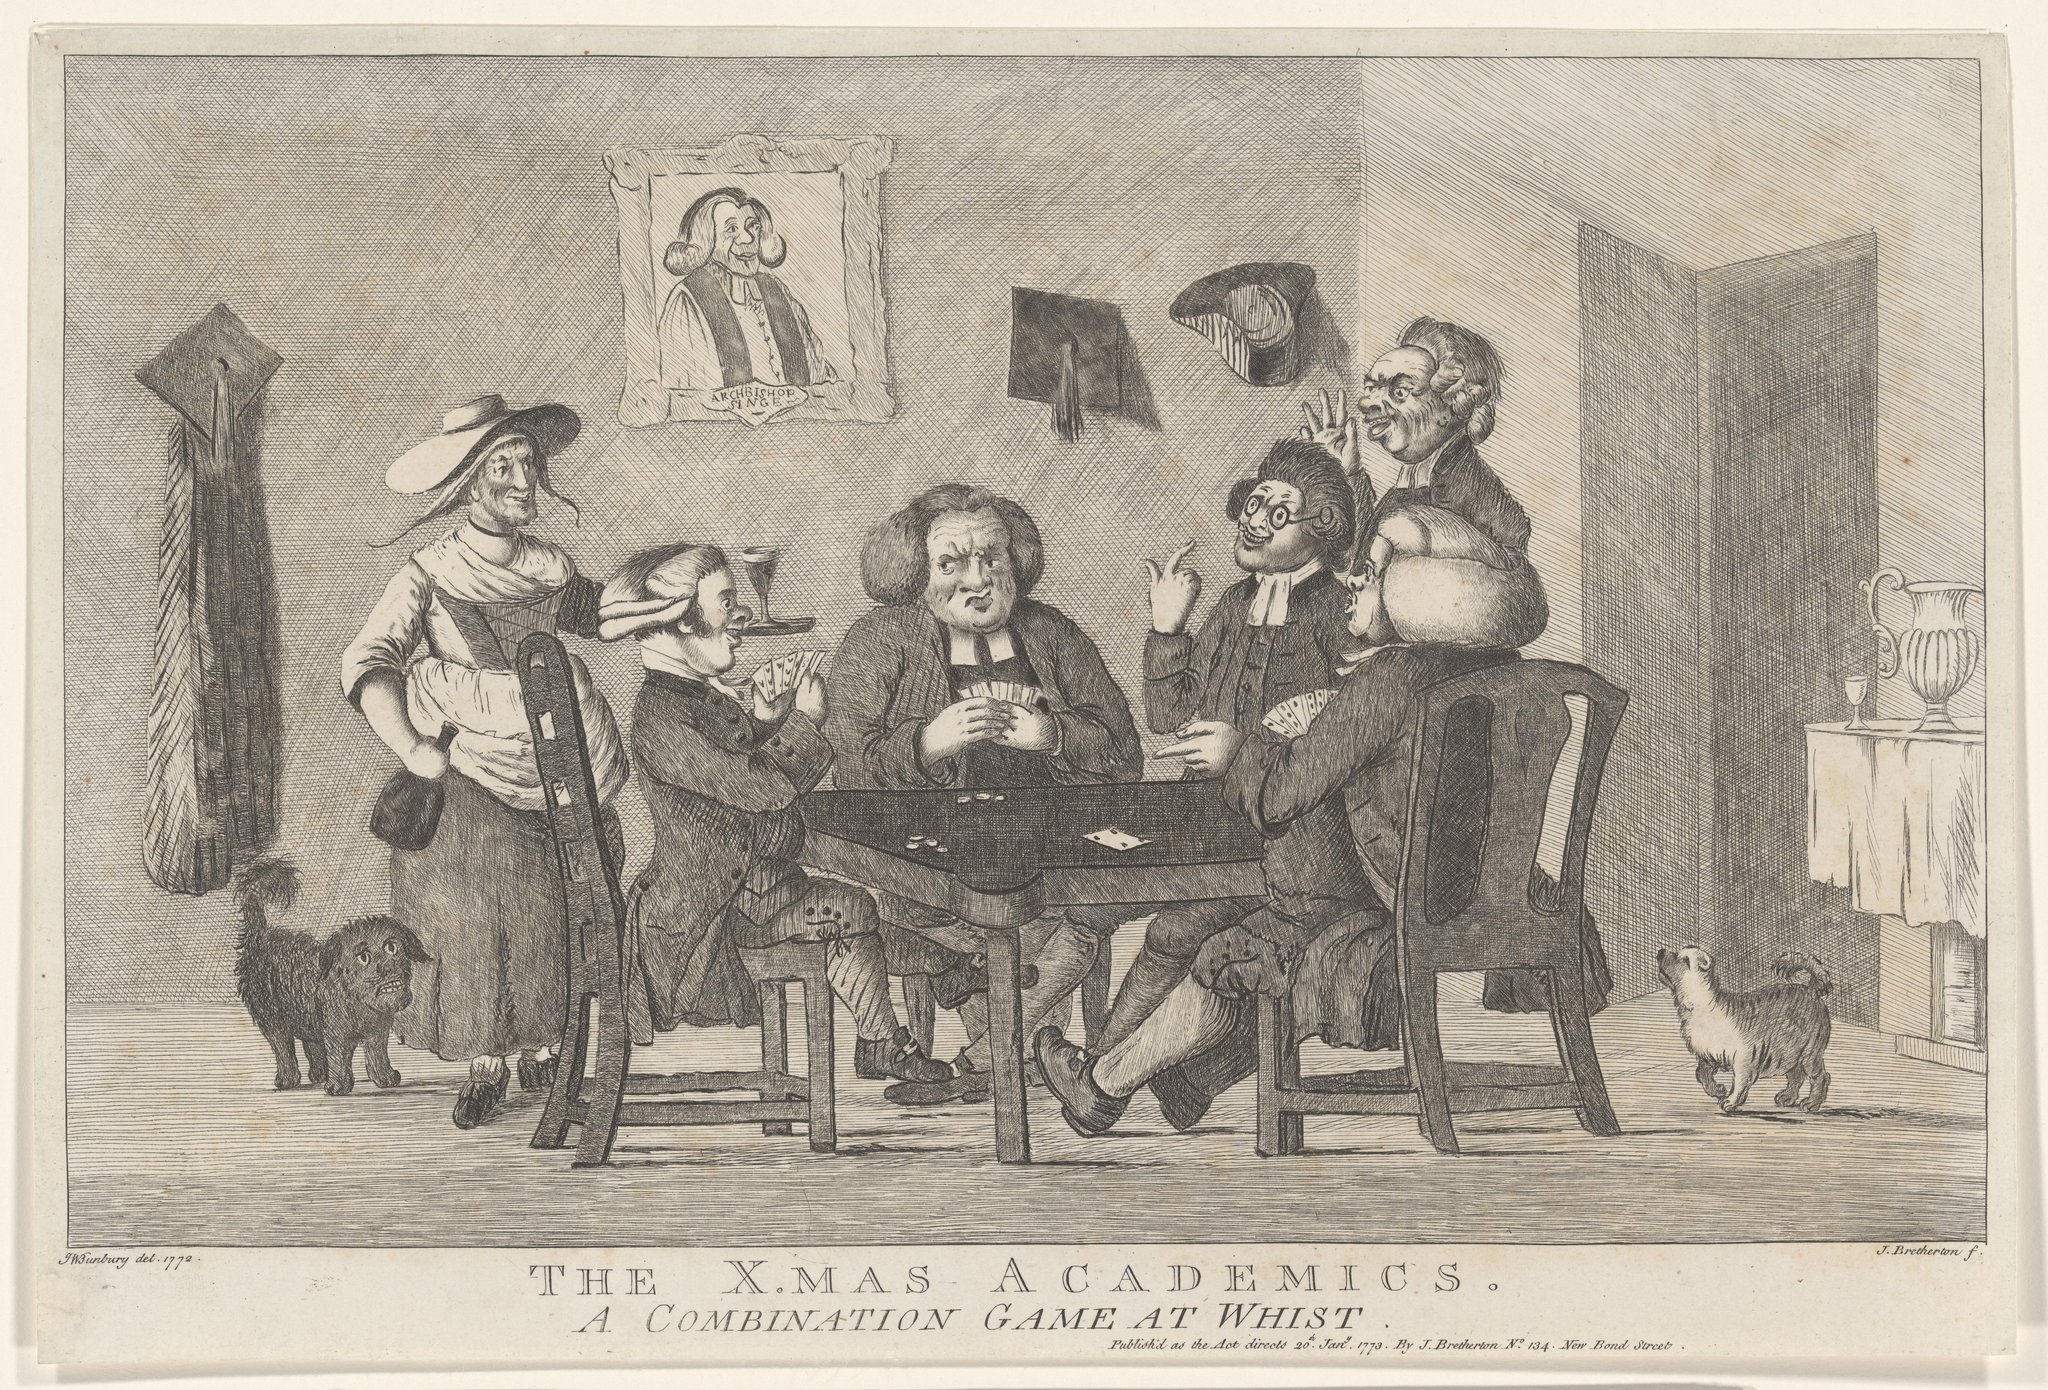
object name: cartoon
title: The Xmas Academics - A Combination Game at Whist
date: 1773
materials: paper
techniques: etching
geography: london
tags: caricatures (human types), group of professors, card games, dog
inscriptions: collector's mark: Lugt 2228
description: Satire op de academici van Cambridge. Vier heren spelen het kaartspel whist en grimassen naar elkaar. Twee bedienden en twee honden staan naast de tafel.